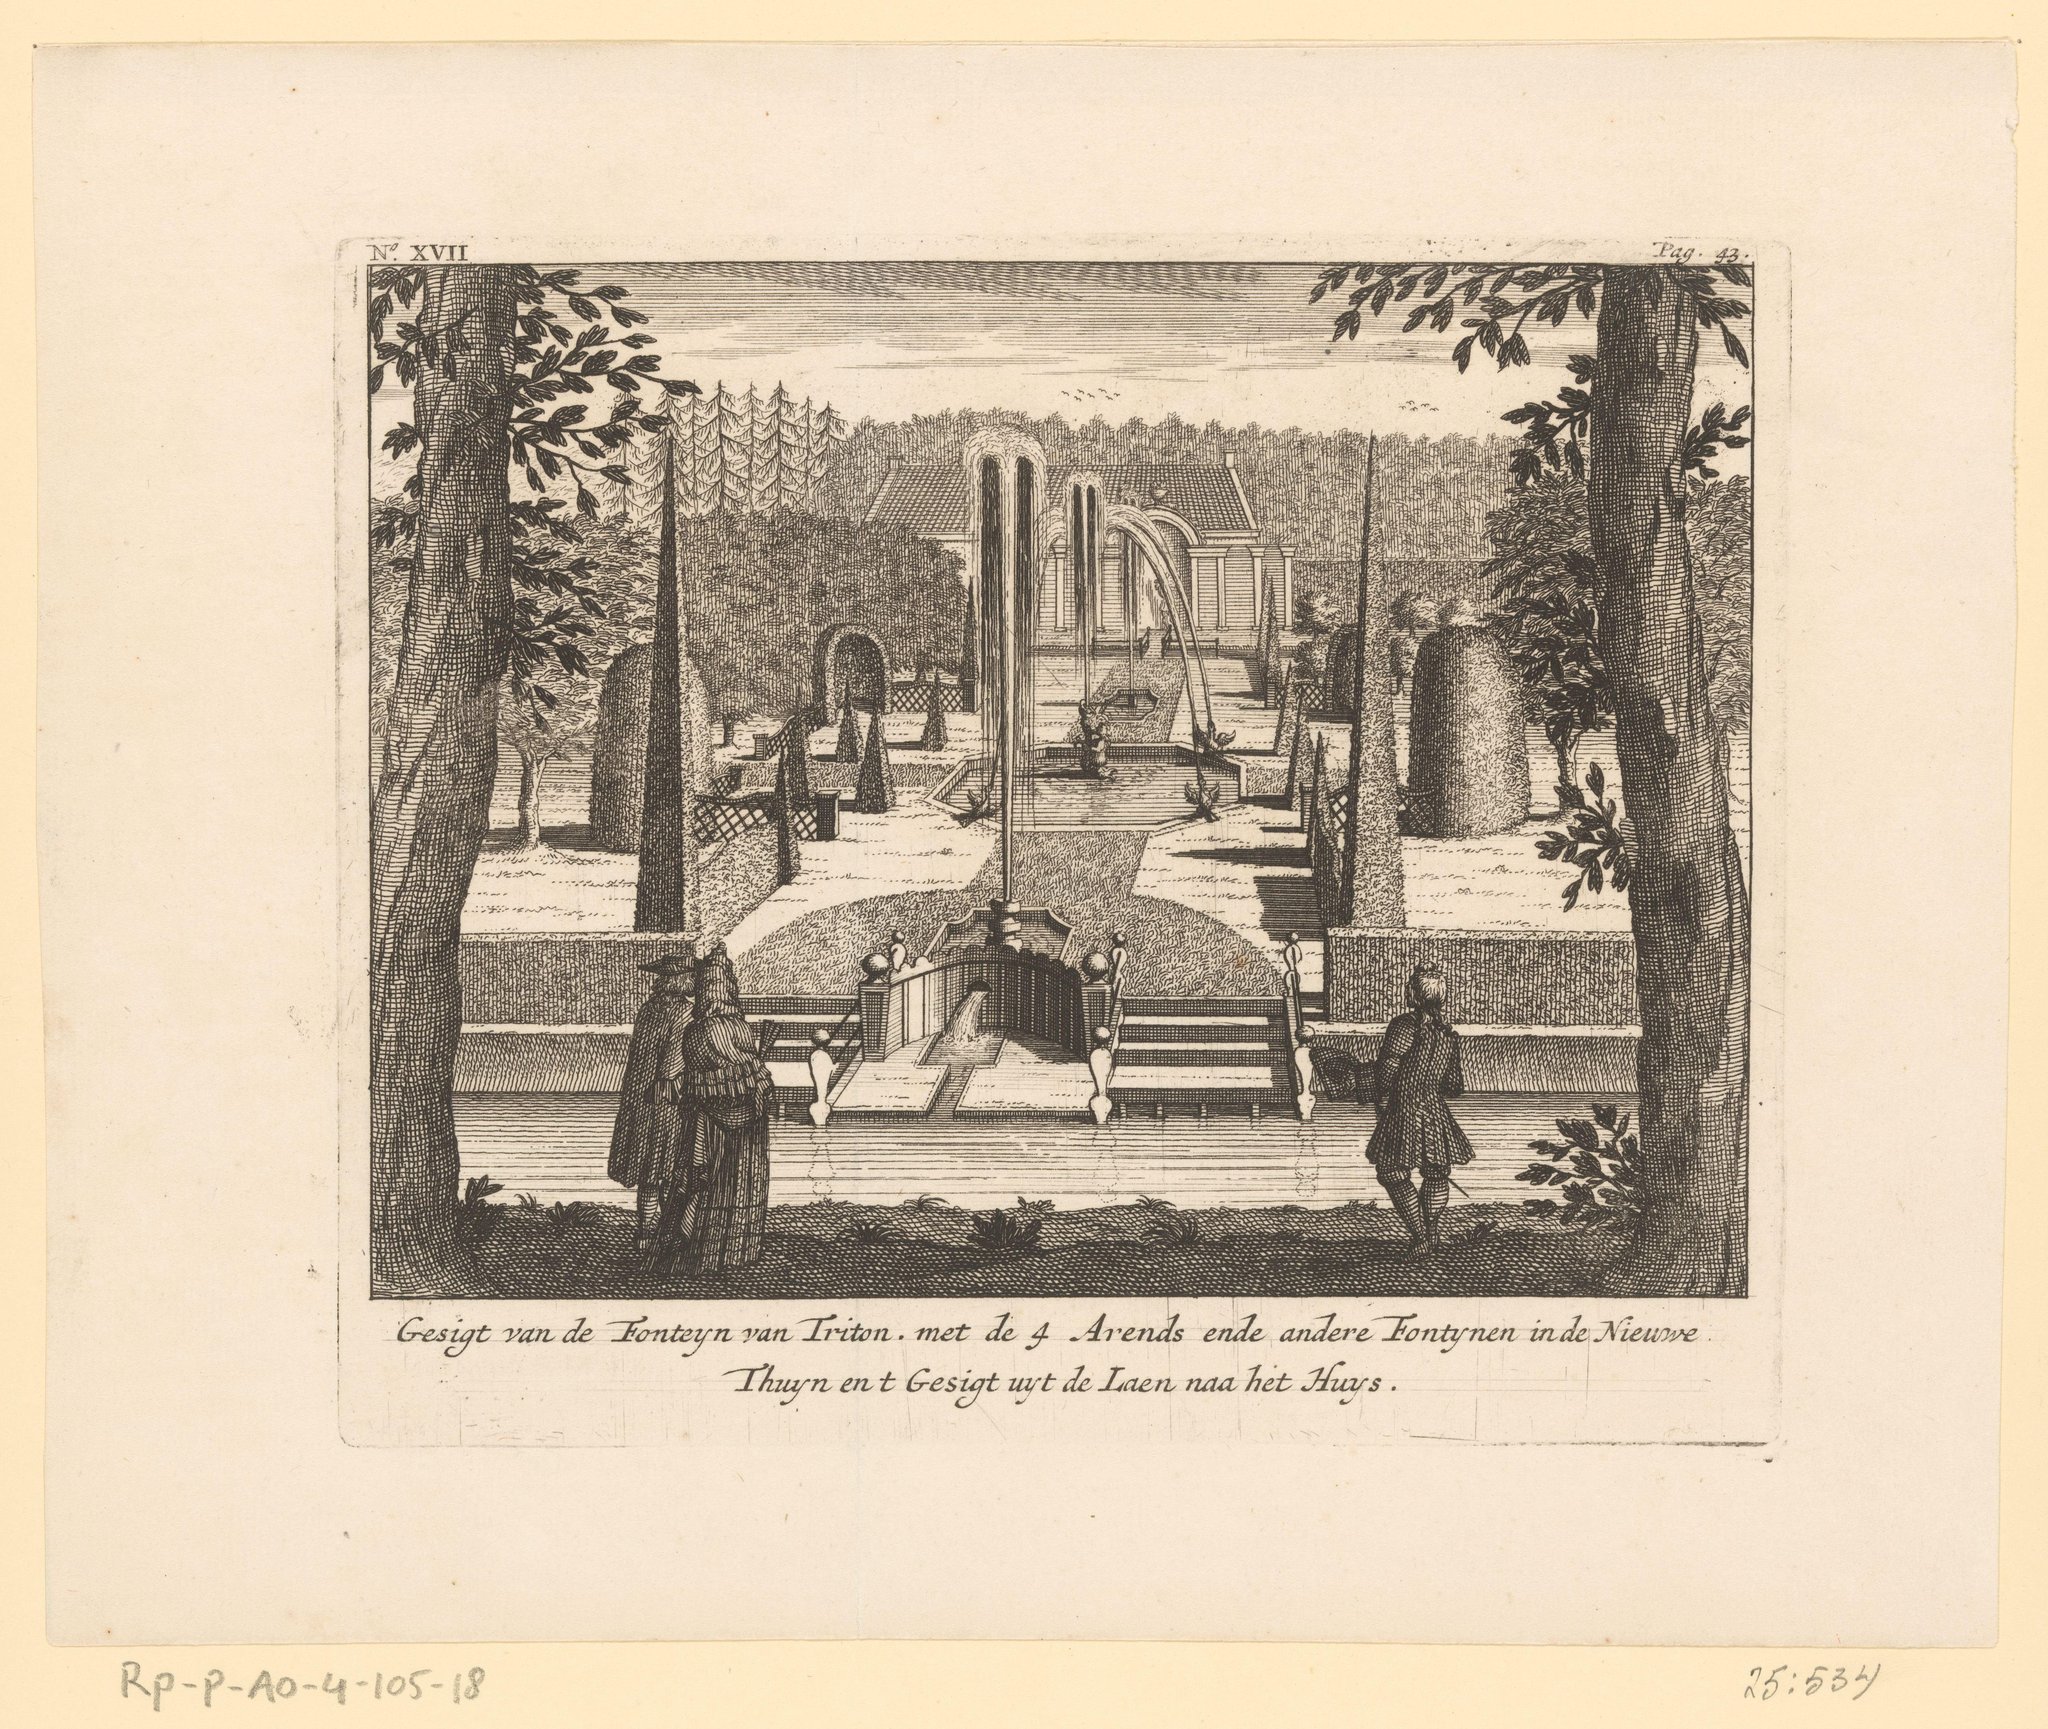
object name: book illustration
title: Gesigt van de fonteyn van Triton, met de 4 arends ende andere fontynen (...)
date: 1718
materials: paper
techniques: engraving, etching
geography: amsterdam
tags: castle, garden fountain, french or architectonic garden; formal garden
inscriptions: collector's mark: Lugt 195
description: Prent ook gebruikt in: Outrein, Johannes d’. Wegwyser door de heerlykheid Roosendaal ofte, de Roosendaalsche vermakelykheden. 3e druk. Amsterdam: Gerard van Keulen, 1718.